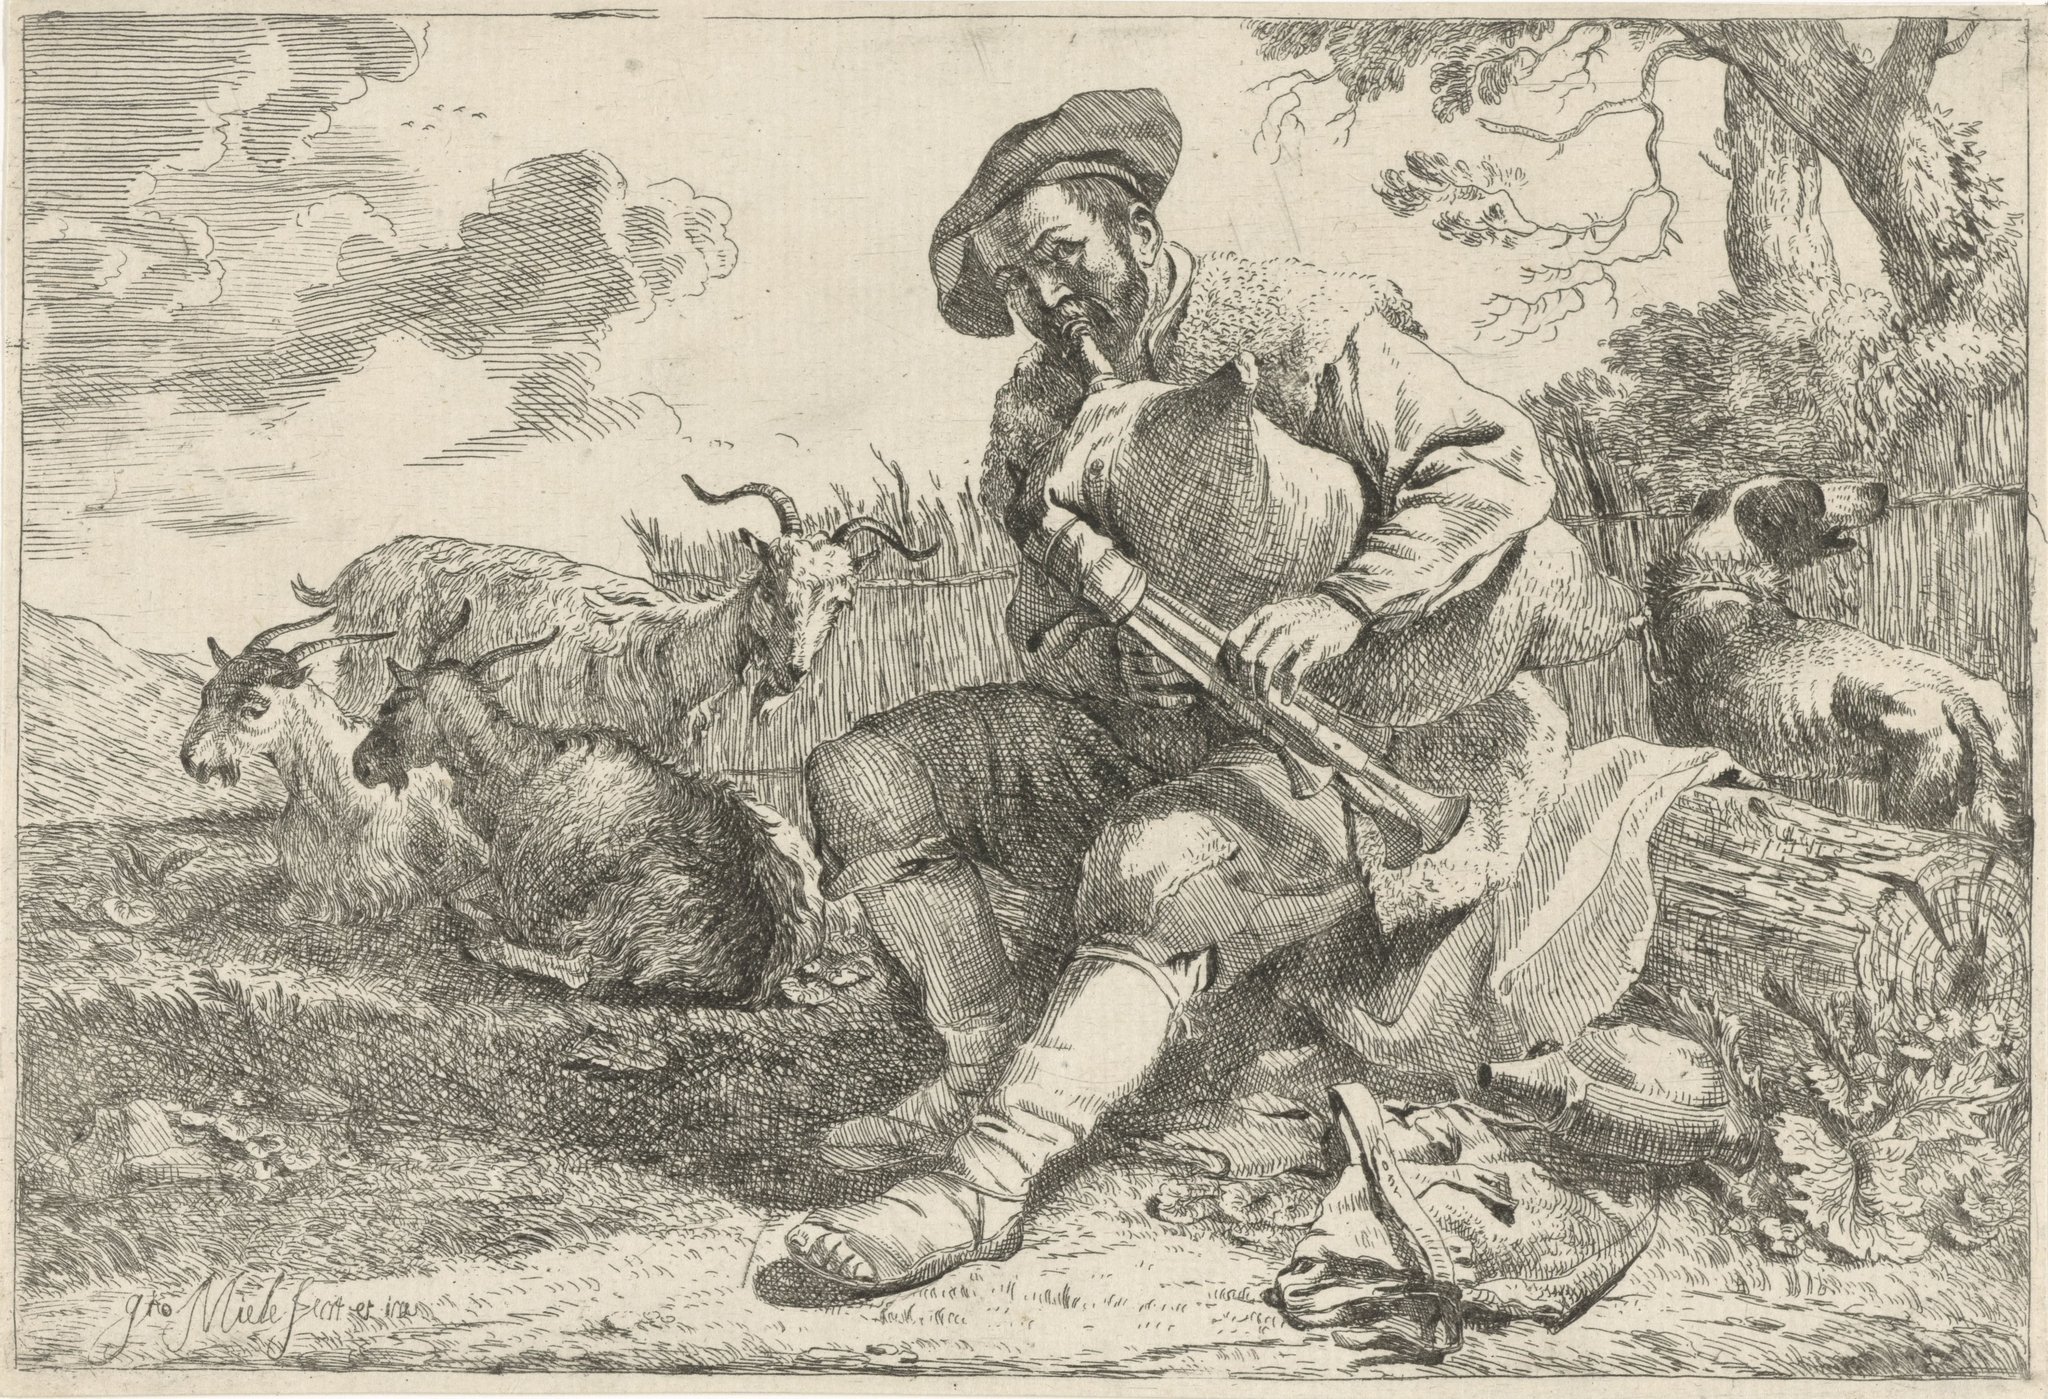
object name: print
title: Herder met doedelzak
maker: jan miel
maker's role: draughtsman, painter, print maker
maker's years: 1599-1663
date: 1599-1664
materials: paper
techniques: etching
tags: herding, herdsman, herdswoman, shepherd, shepherdess, cowherd, etc., bagpipe, musette, goat, dog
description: Een op een boomstam zittende herder speelt op een doedelzak. Links drie geiten. Rechts achter hem een hond.